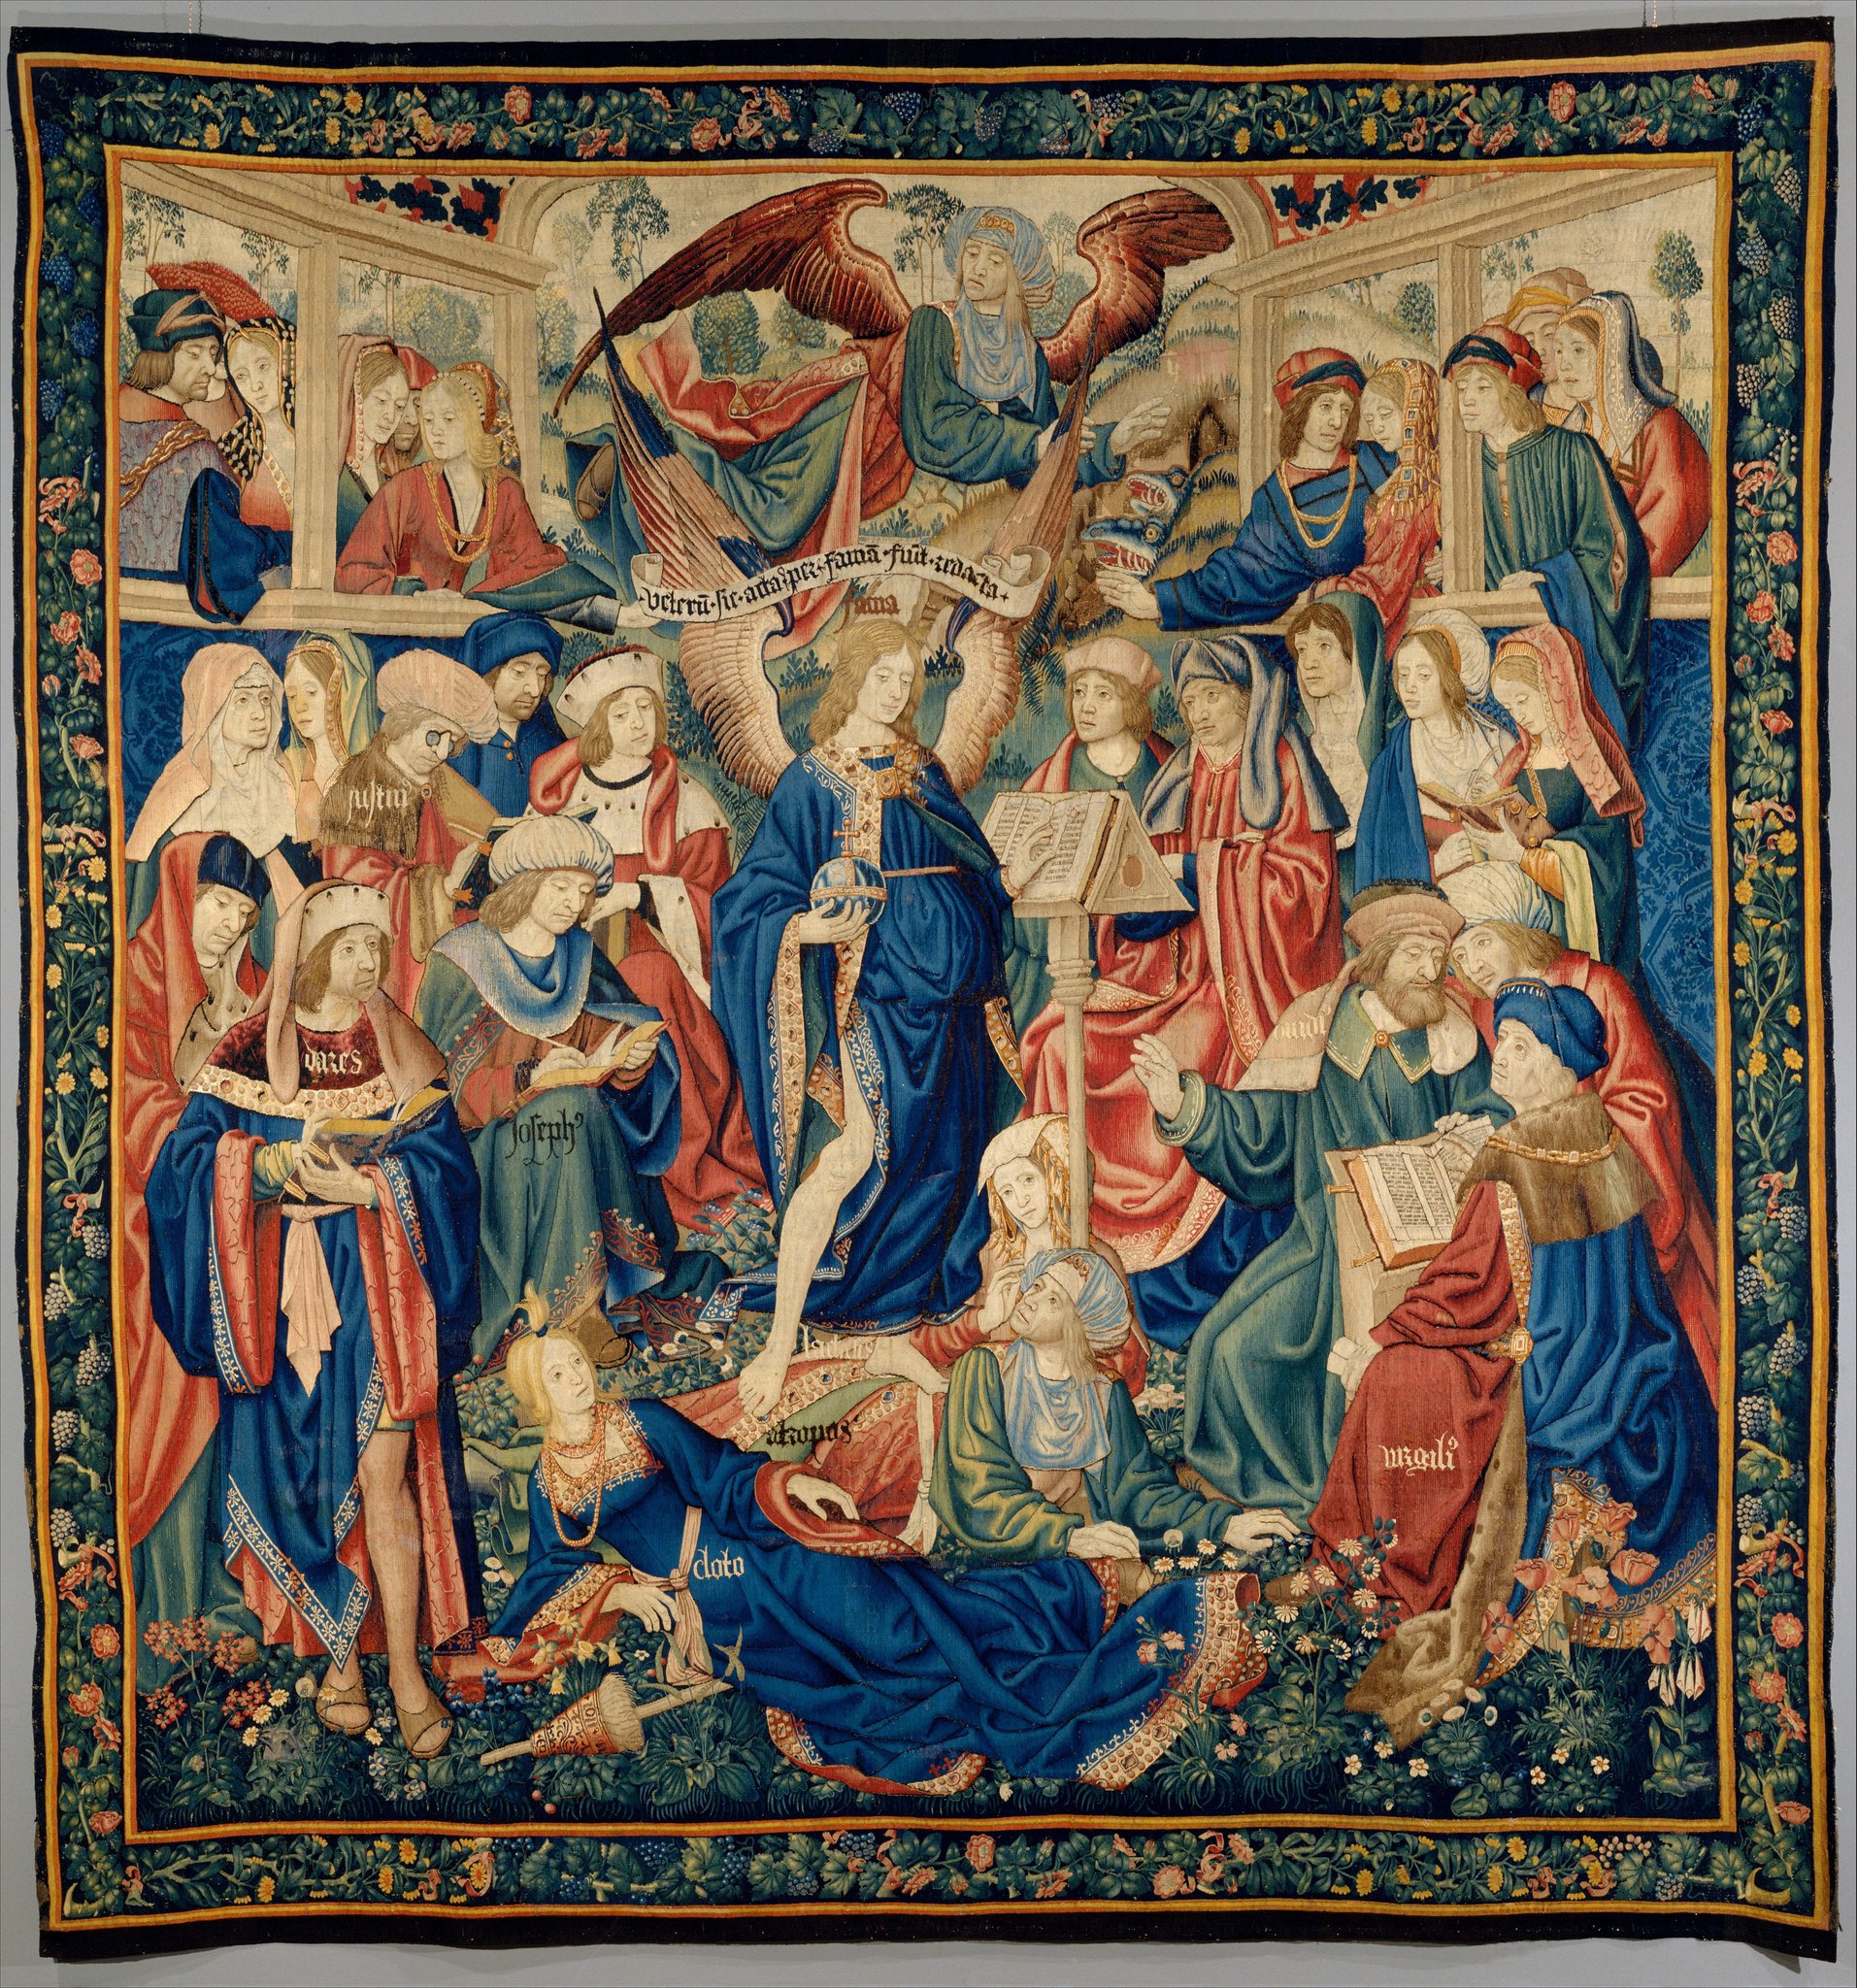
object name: tapestry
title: The Triumph of Fame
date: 1502-1504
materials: silk, wool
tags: fruit,men,women,flowers,writing,allegory